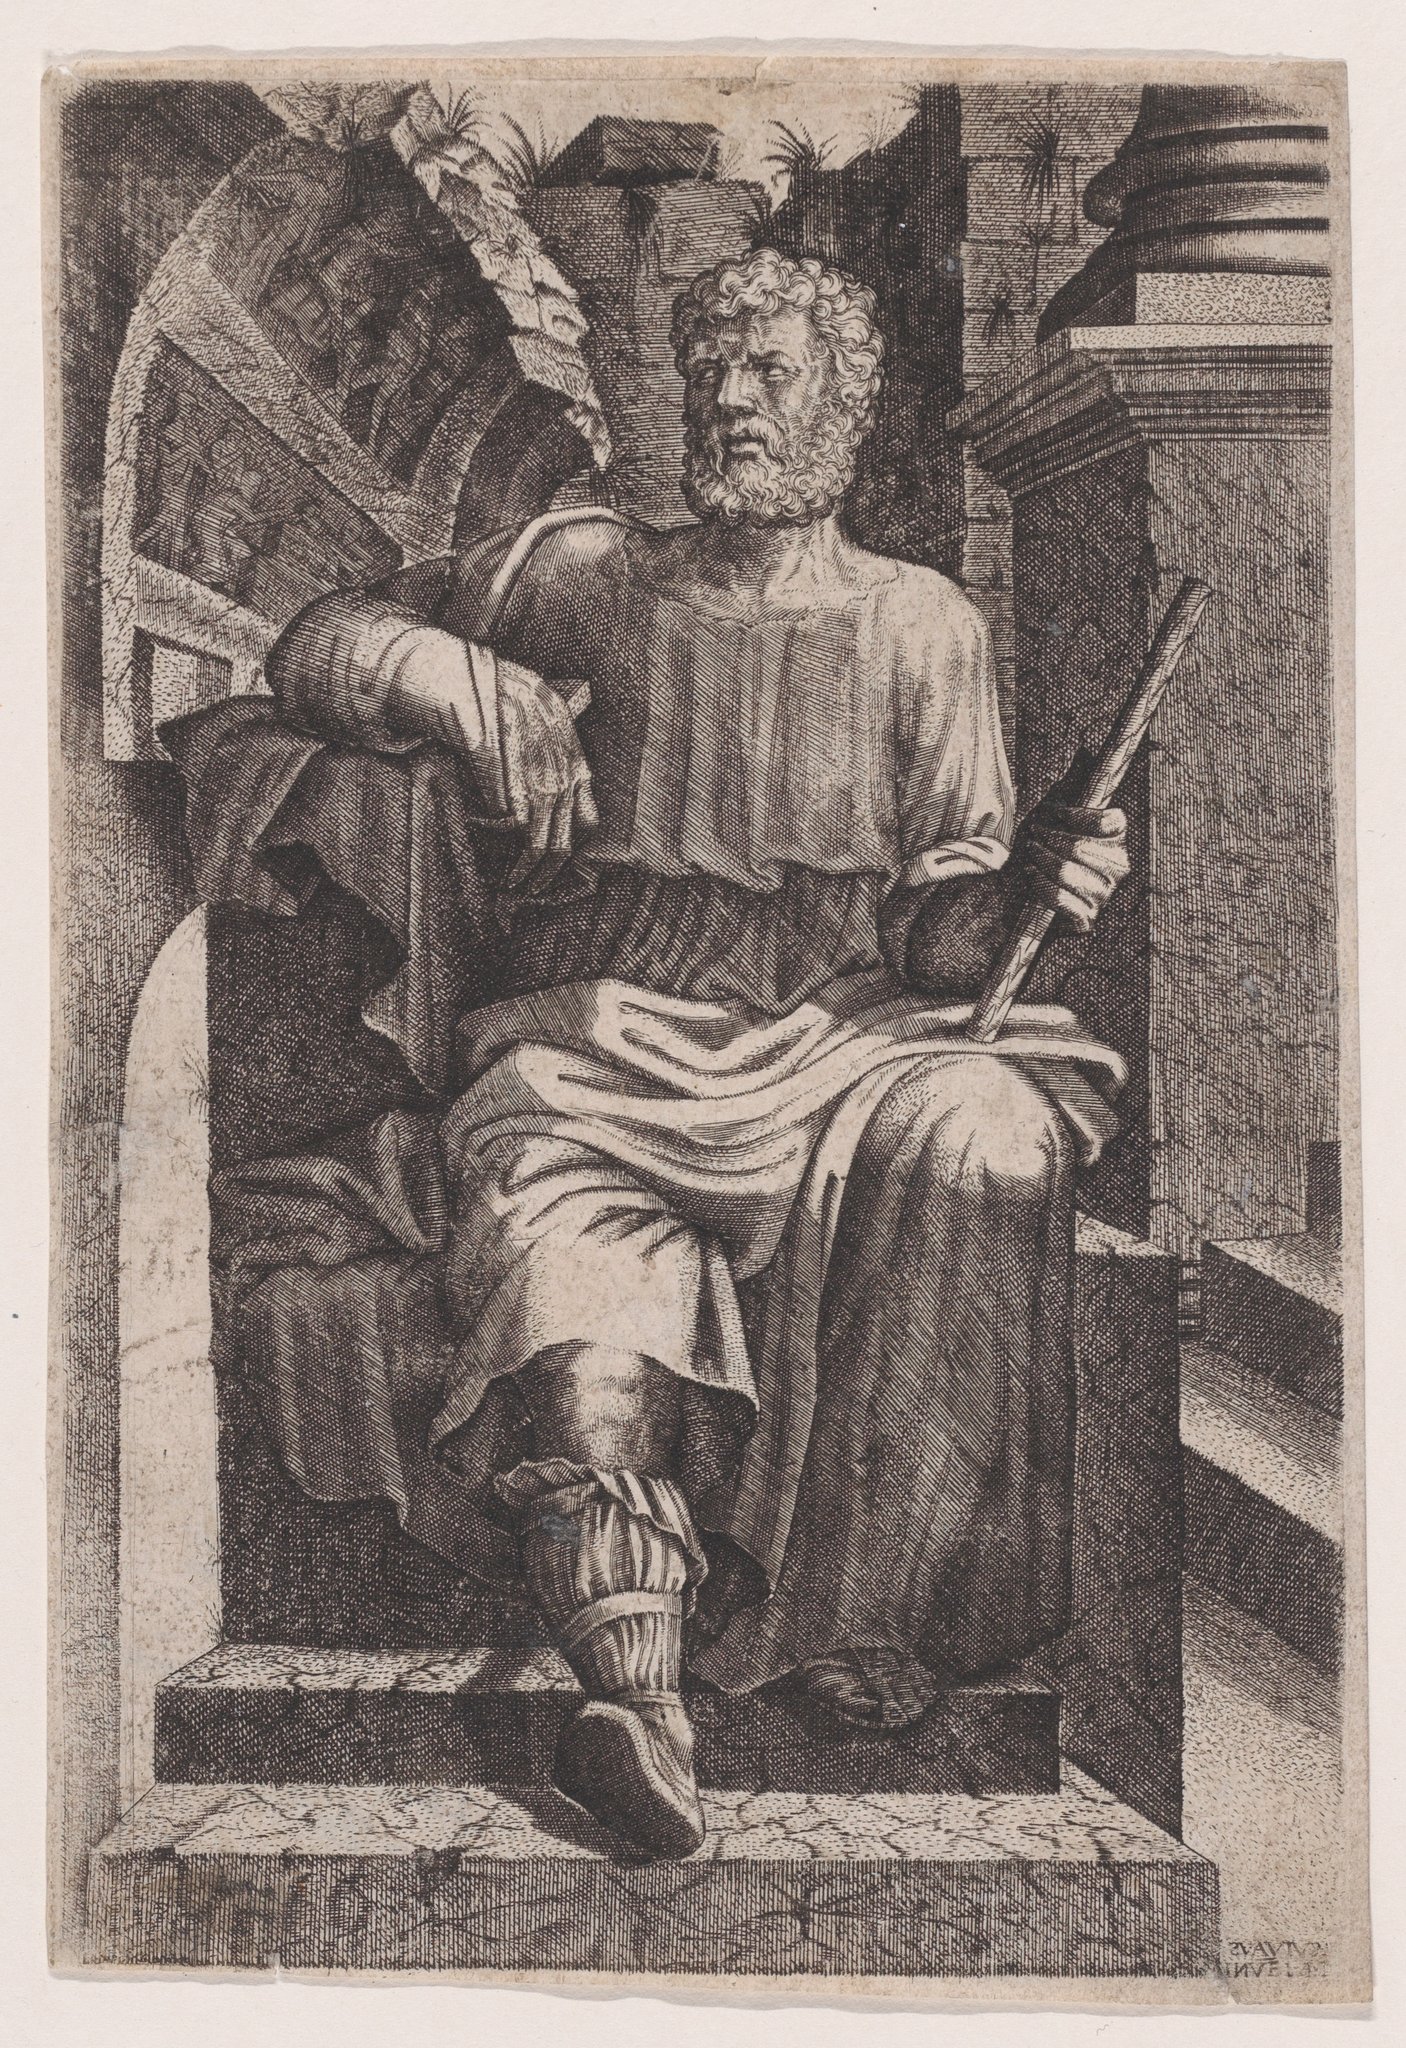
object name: print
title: Roman General (?) Seated before Ruins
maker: lambert suavius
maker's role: artist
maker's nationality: netherlandish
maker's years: 1510-1576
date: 1525-1576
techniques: engraving